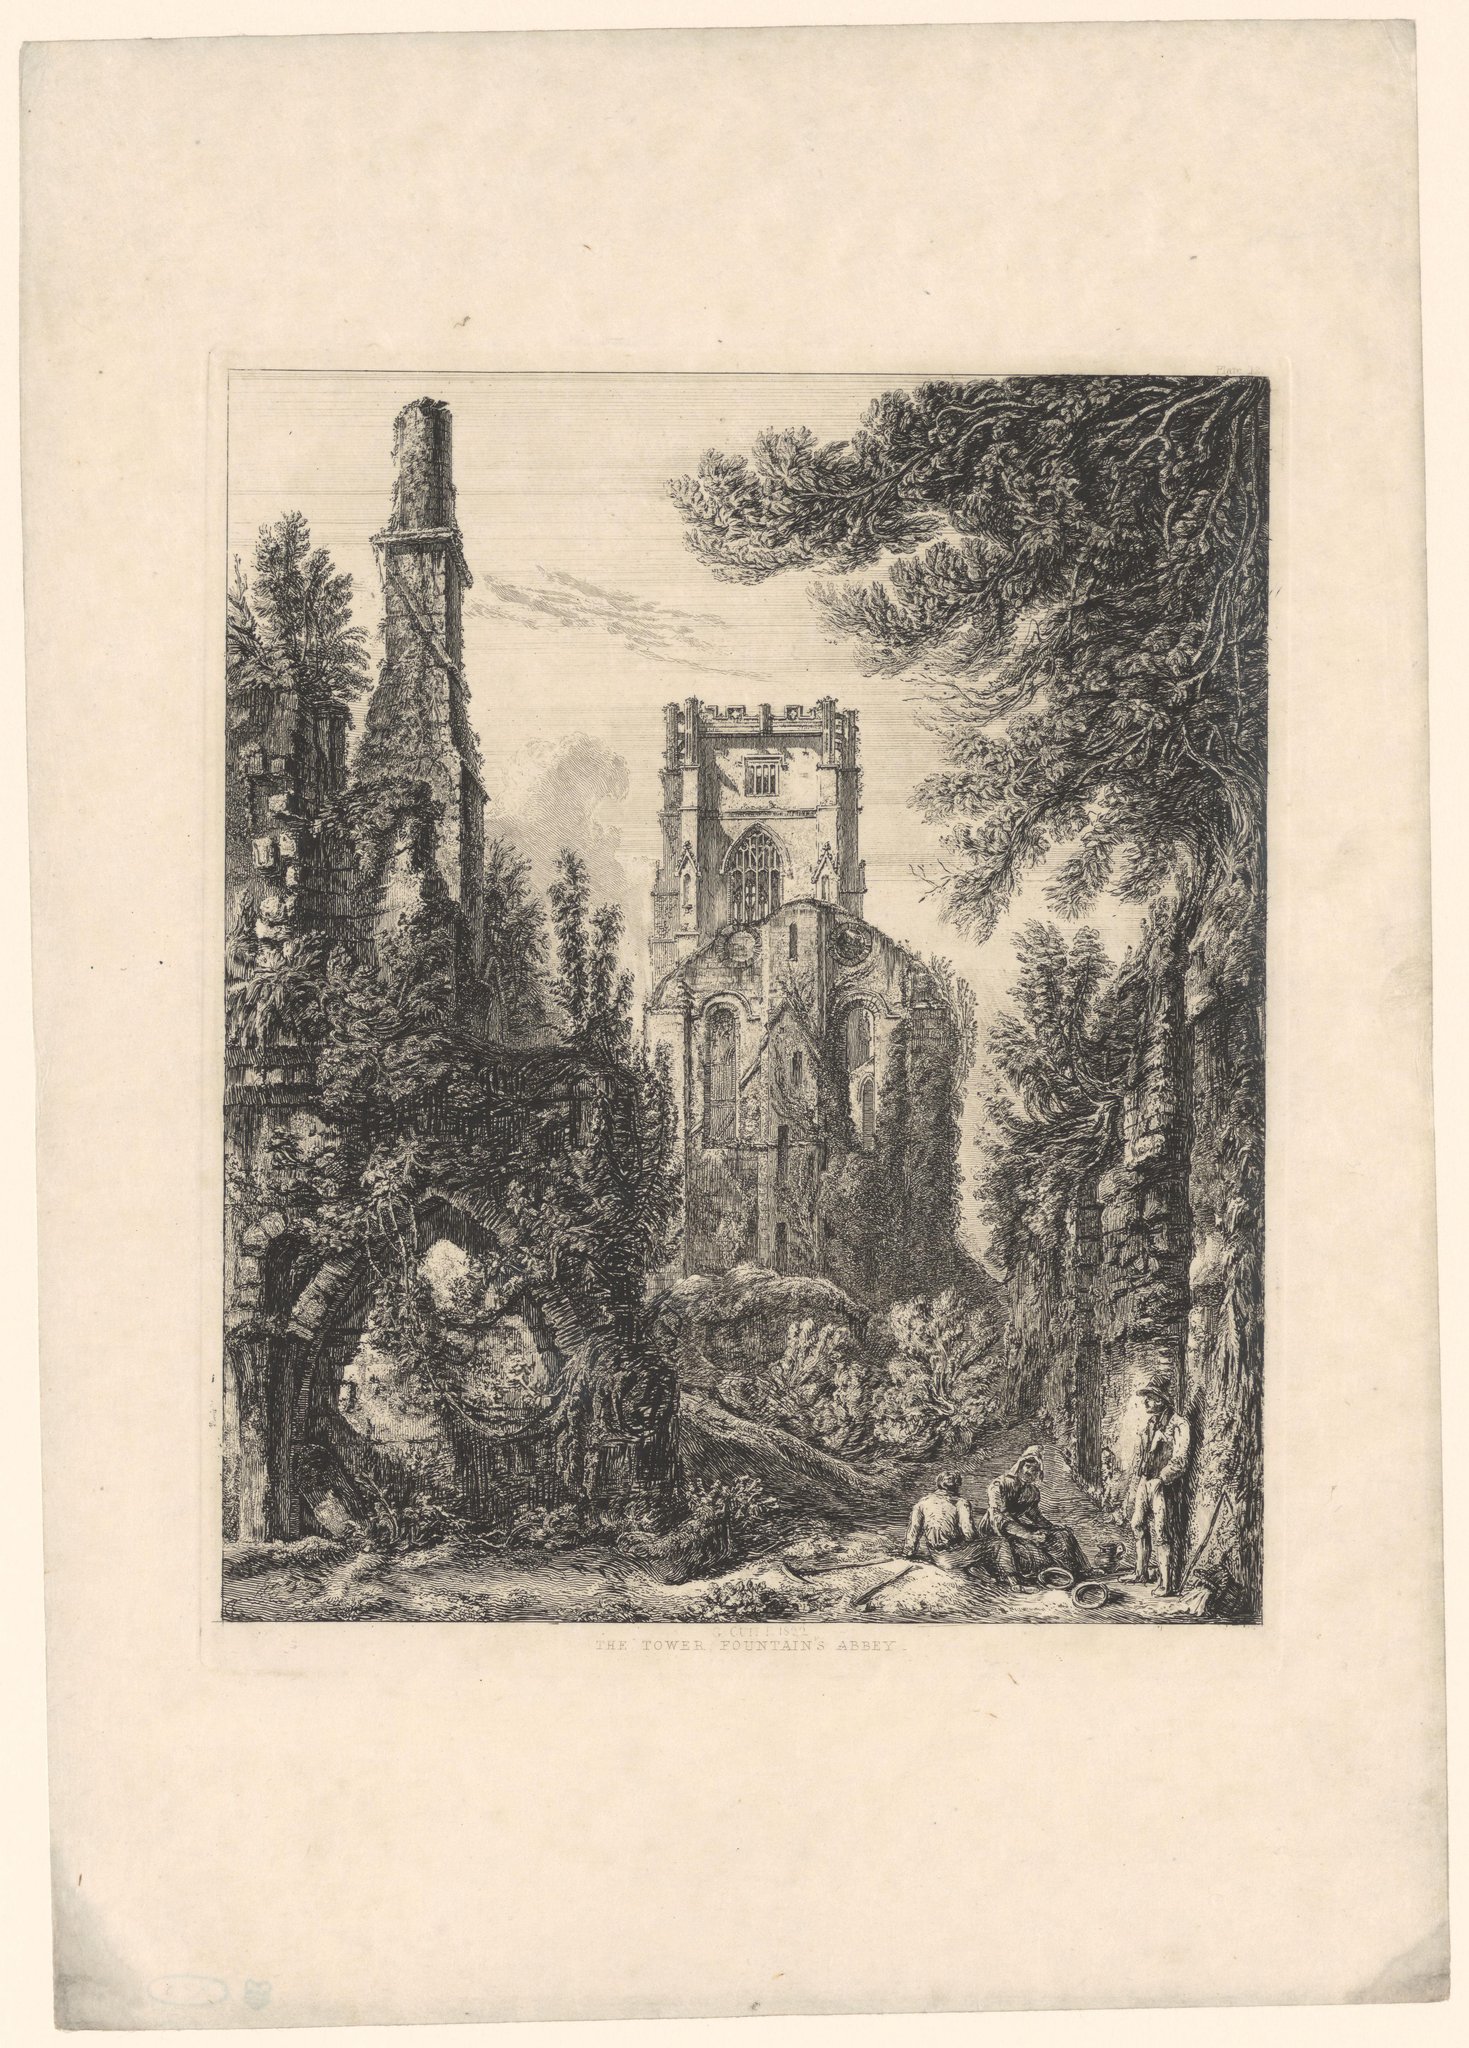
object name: print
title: Wanderings and Pencillings Amongst Ruins of the Olden Time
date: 1822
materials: paper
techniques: etching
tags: abbey, monastery, convent ~ roman catholic church, ruin of church, monastery, etc.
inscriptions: collector's mark: Lugt 2760, collector's mark: Lugt 2228